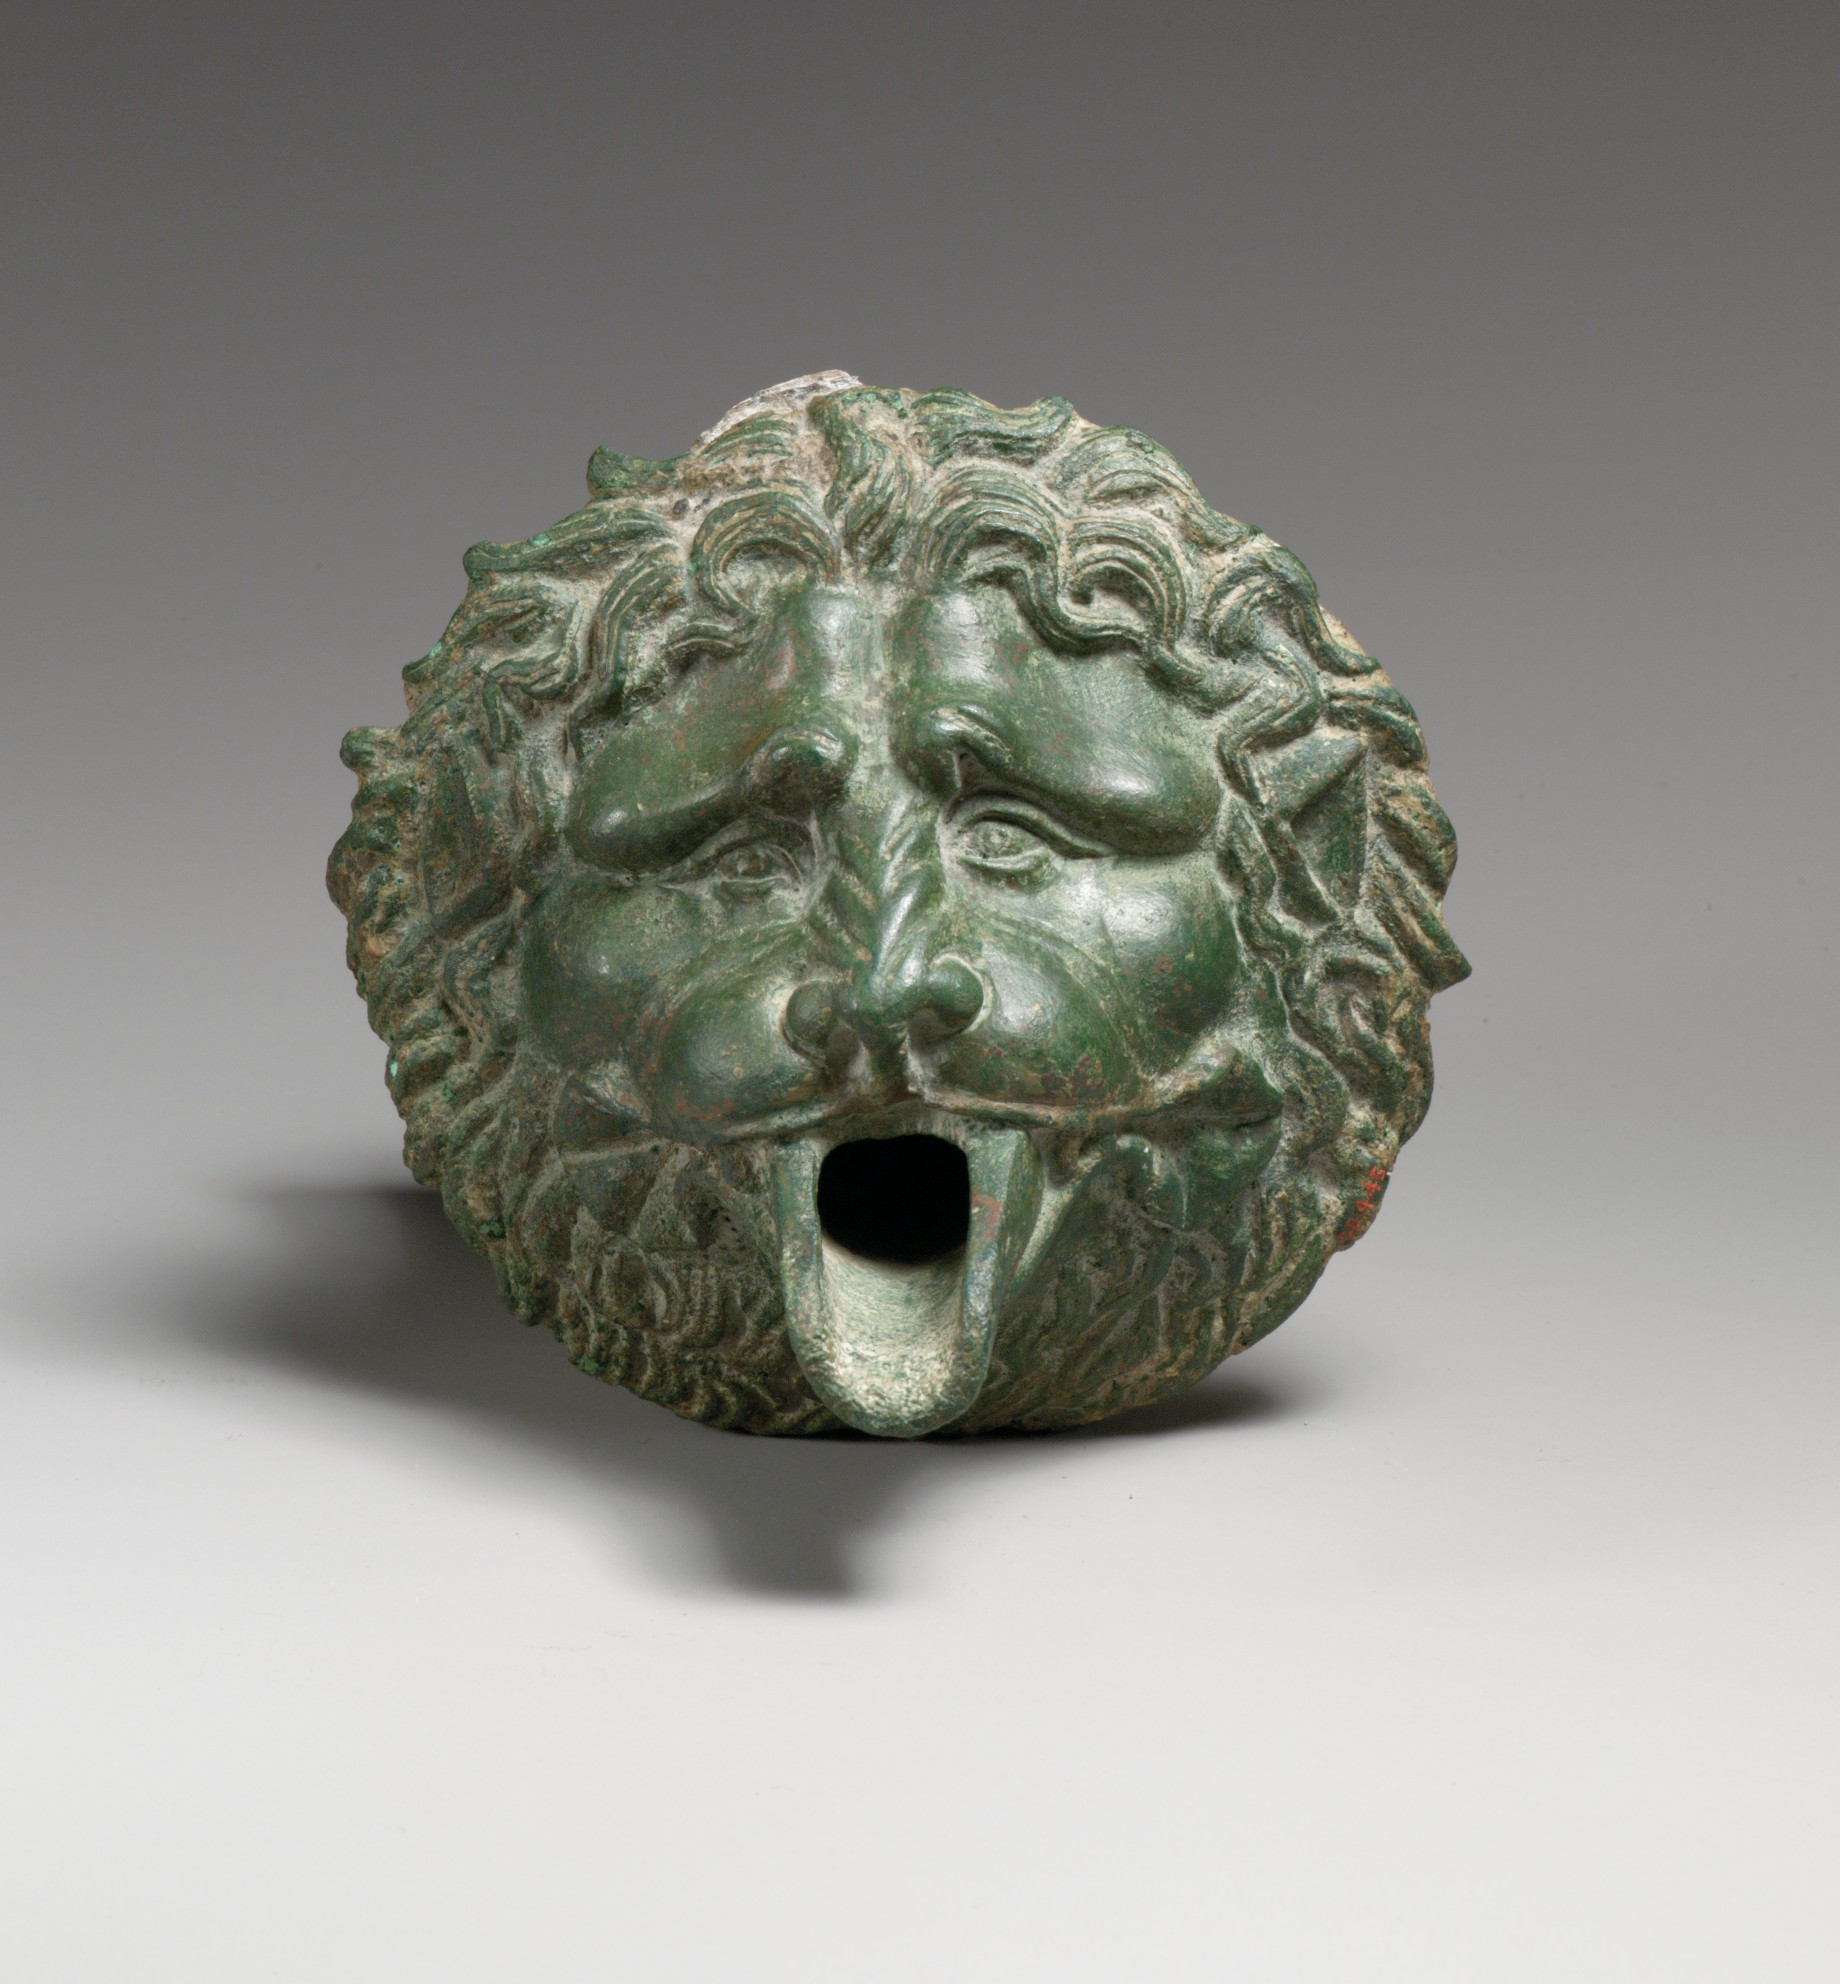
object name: spout with lion mask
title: Bronze water spout in the form of a lion mask (one of a pair)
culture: greek or roman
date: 100 BCE-100 CE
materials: bronze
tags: masks,lions